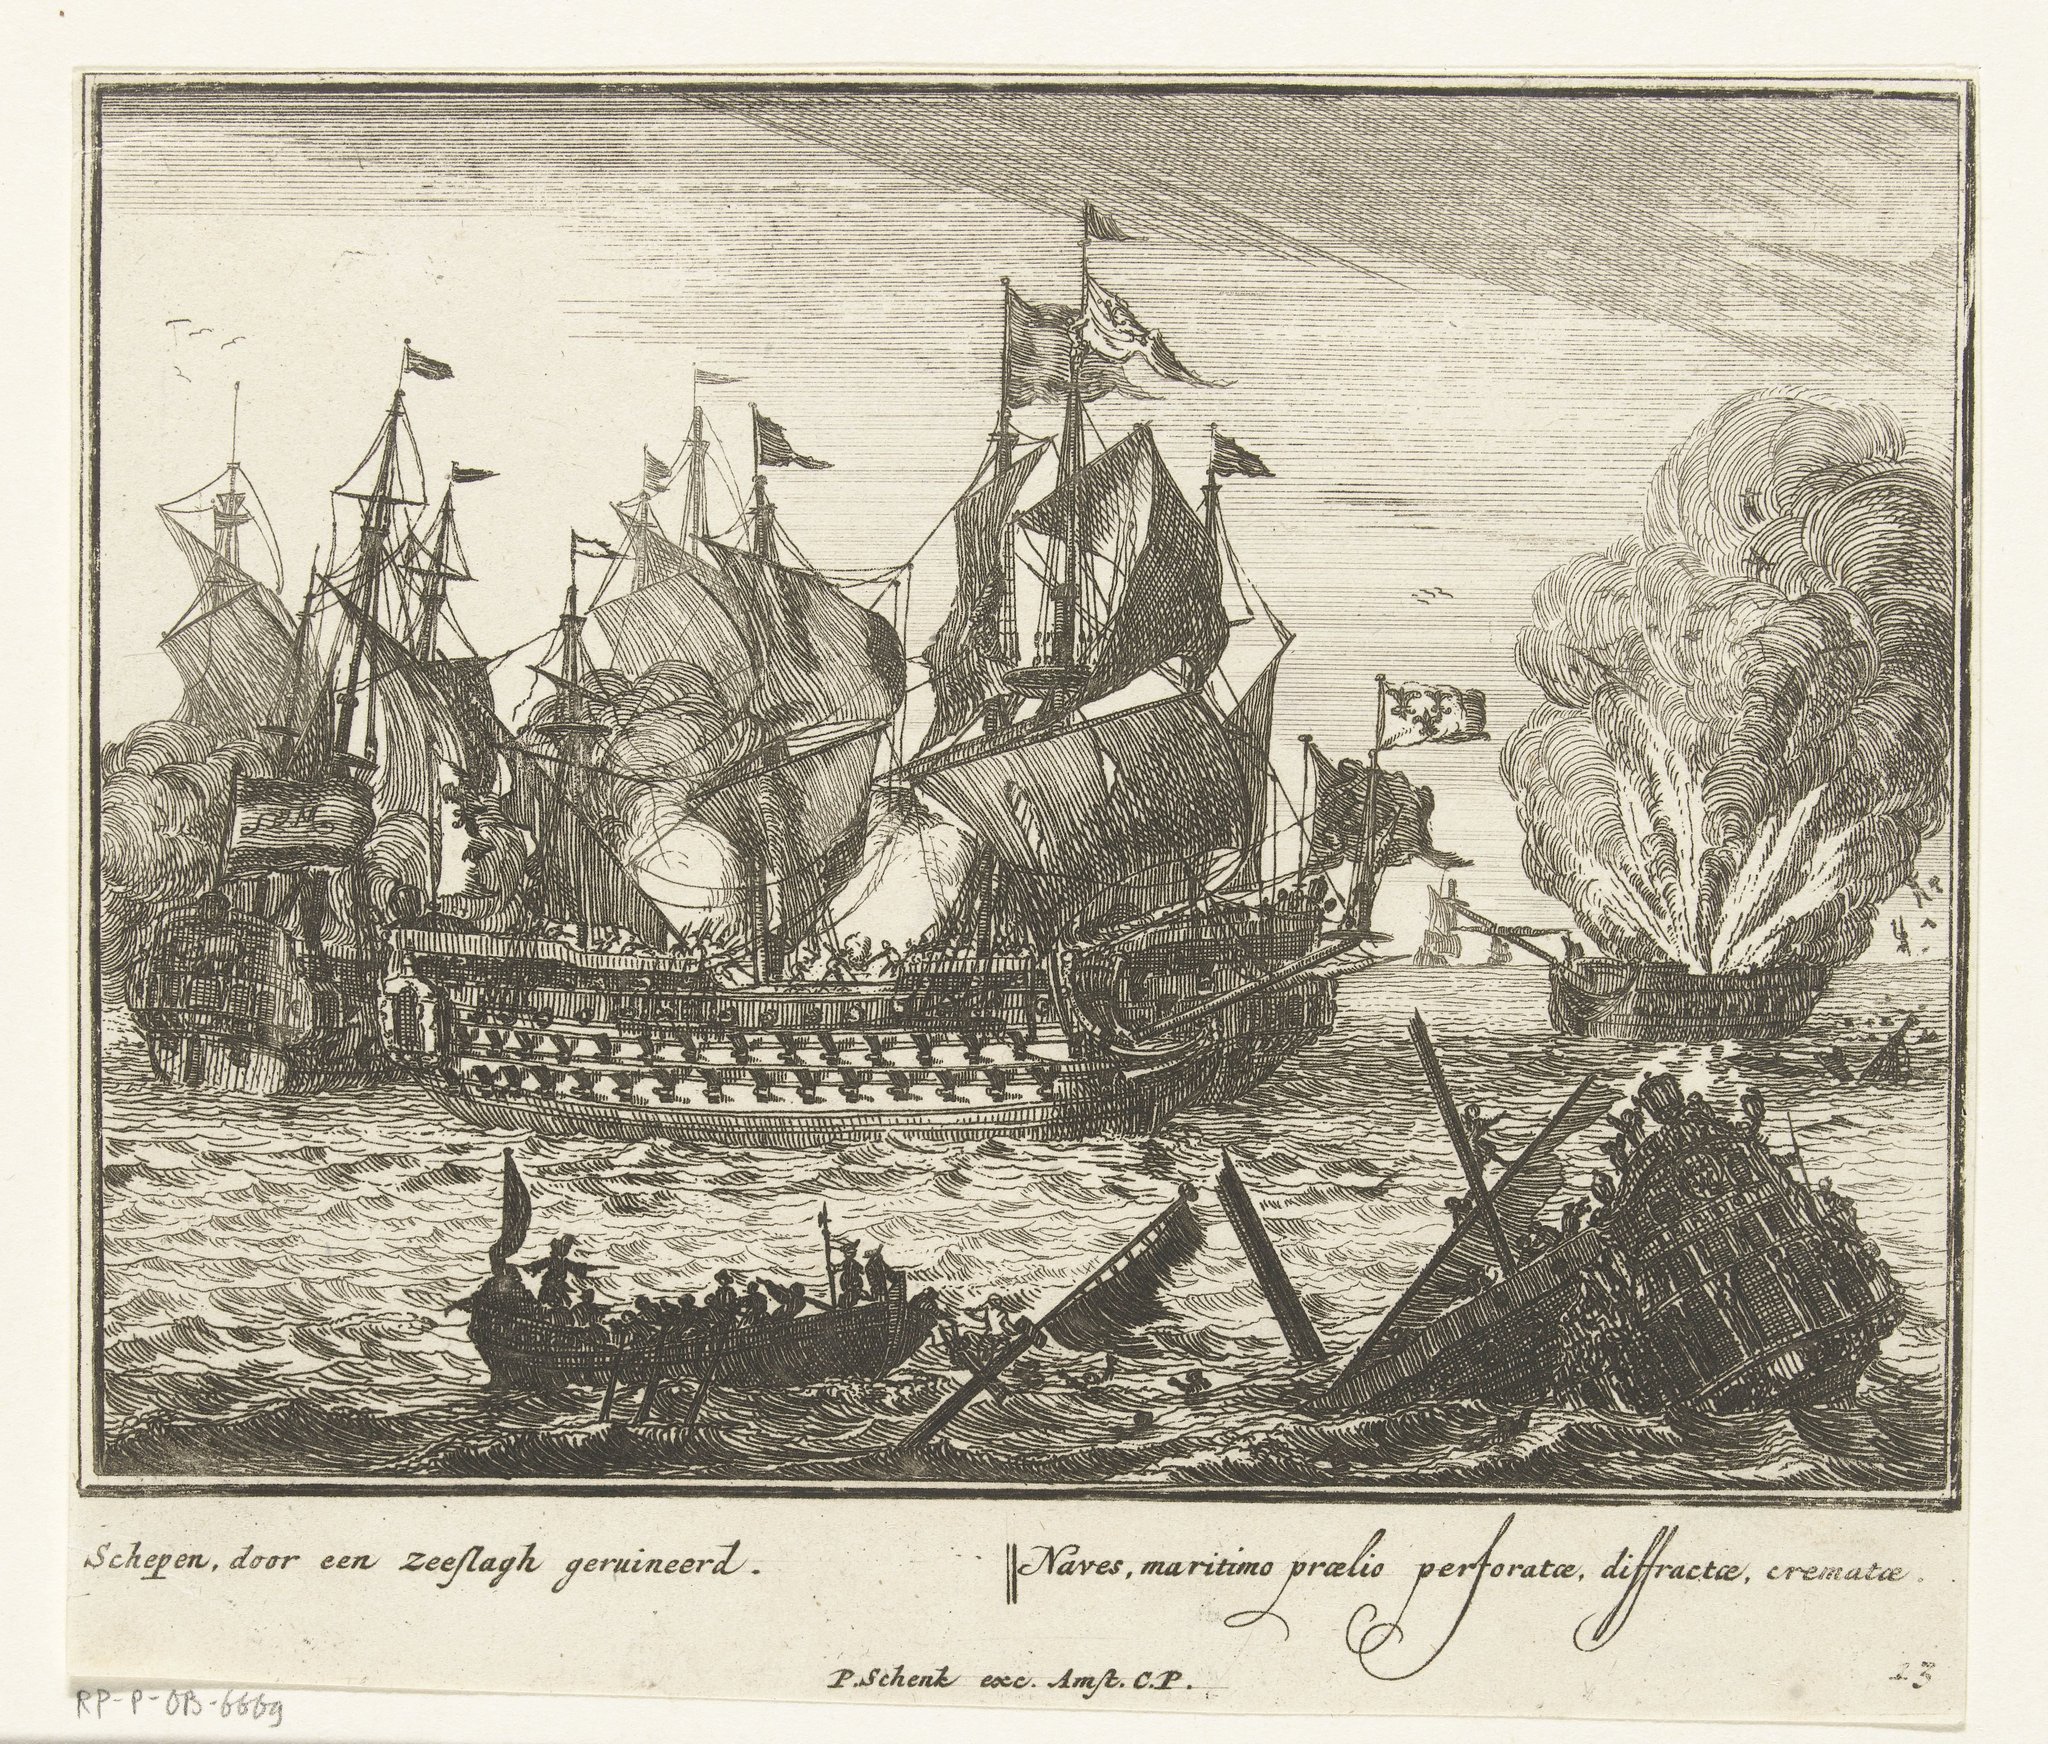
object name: print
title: Schepen, door een zeeslagh geruineerd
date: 1690-1710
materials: paper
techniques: etching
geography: northern netherlands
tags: battle (+ naval force)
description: Schepen verwoest tijdens een zeeslag met een Franse vloot. No. 13 uit serie van 16 prenten waarop de bouw en lotgevallen van een schip zijn afgebeeld. Met onderschriften in het Nederlands en Latijn.